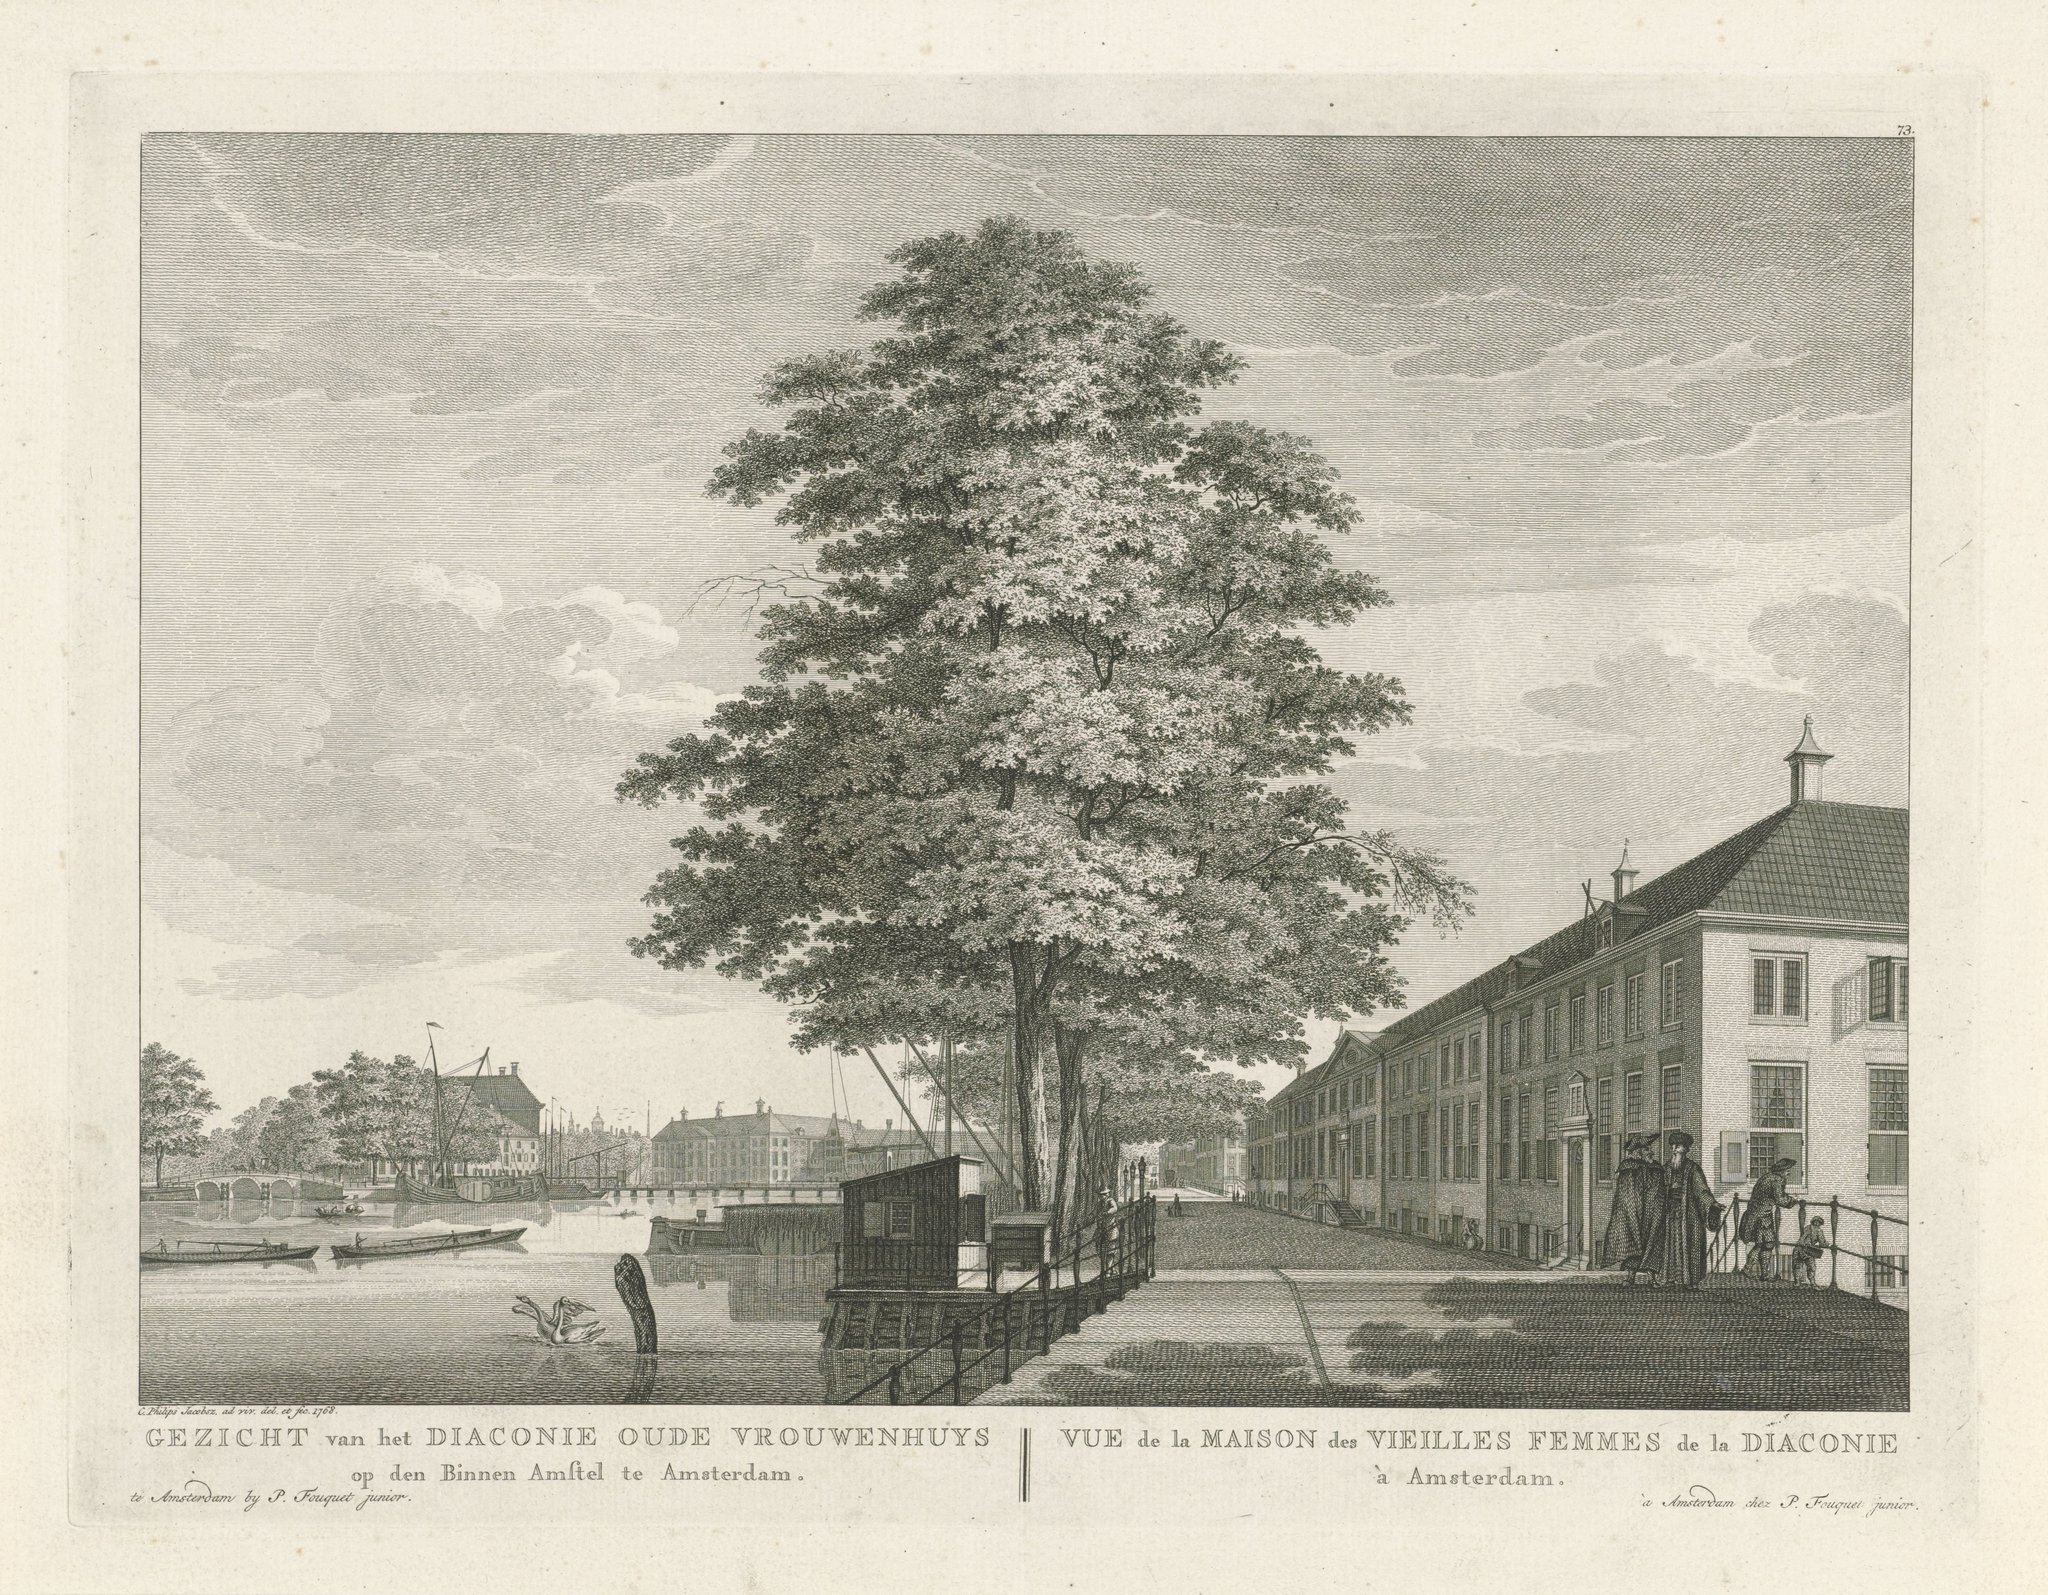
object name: print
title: Gezicht op het Diaconie Oude Vrouwen- en Mannenhuis te Amsterdam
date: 1768-1783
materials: paper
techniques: engraving, etching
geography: amsterdam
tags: bridge in city across river, canal, etc. (+ city(-scape) with figures, staffage), public welfare, orphanage, canals, waters (in city) (+ city(-scape) with figures, staffage), old-people's home, street (+ city(-scape) with figures, staffage)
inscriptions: collector's mark: Lugt 2233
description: Deze prent is ook gebruikt in de zogenaamde Atlas van Fouquet.* Pierre Fouquet gaf vanaf 1760 stadsgezichten van Amsterdam - naar tekeningen van verschillende kunstenaars, gemaakt door verschillende prentmakers - uit. Deze prenten werden aanvankelijk los of in series verkocht. Zoals toen gebruikelijk kon de koper de prenten zelf laten inbinden. Hiertoe gaf Fouquet tussen 1778 en 1783 een titelblad, plattegrond en inhoudsopgave van de tot dusver 100 uitgegeven prenten uit (1). Gezien de inhoud afhankelijk was van wat de koper had verzameld verschilt de inhoud van de verschillende bewaarde Fouquetatlassen onder deze titel sterk. Ook zijn er exemplaren bekend waar tevens andere prenten aan zijn toegevoegd. Omdat er behoefte bleek aan uitleg bij de platen werd in 1783 een nieuwe versie van de atlas uitgegeven, aangevuld met tekst en twee prenten. De aangegeven volgorde veranderde maar de platen van de al eerder uitgegeven prenten bleven ongewijzigd. Deze uitgave werd in opdracht van Fouquet gedrukt bij Daniël Jean Changuion en Petrus den Hengst (2). Een tiental platen werd bijgewerkt en verscheen, met nieuw impressum, in het vervolg van Wagenaars geschiedenis van Amsterdam, uitgeven door Petrus Conradi en Folkert van der Plaats (3). Een aantal jaar na het overlijden van Fouquet kwam Evert Maaskamp met een nieuwe uitgave van de atlas, met verbeterde tekst en toevoeging van twee prenten. Op alle platen verwijderde hij het oude en liet hij zijn eigen impressum zetten (4). De huidige staat van de prent komt voor in exemplaren van de onder (1) en (2) genoemde werken. * Onder de Atlas van Fouquet of Fouquetatlas verstaan we de hieronder vermelde publicaties (1), (2) en (4). (1). Afbeeldingen van de wyd-vermaarde koopstad Amsterdam benevens des zelvs voornaamste gebouwen en gezigten alle naar het leeven getekend / Receuil des edifices les plus considerables et des plus belles vues, de la fameuse ville d'Amsterdam, dessinées d'après nature. Amsterdam: Pierre Fouquet, 1778-1783. (2). Nieuwe atlas, van de voornaamste gebouwen en gezigten der stad Amsterdam, met derzelver beknopte beschryvingen. 2 delen. Amsterdam: Daniël Jean Changuion en Petrus den Hengst [in opdracht van Pierre Fouquet], 1783. (3). Stijl, Simon. Amsterdam, in zyne geschiedenissen, voorregten, koophandel, gebouwen, kerkenstaat, schoolen, schutterye, gilden en regeeringe, beschreeven. Om te dienen ten vervolge op het werk van Jan Wagenaar (…). 10 delen. Amsterdam en Harlingen: Petrus Conradi en Folkert van der Plaats, 1788-1801. (4). Nieuwe atlas, van de voornaamste gebouwen en gezigten der stad Amsterdam. Met derzelver beknopte beschryvingen. Amsterdam: Evert Maaskamp, 1805. * Het aantal vermelde staten is gebaseerd op het aantal gevonden staten. Mogelijk zijn er meer staten van deze prent. Voor eerste bekende staat zie RP-P-1921-578. Voor tweede bekende staat zie RP-P-1905-577.